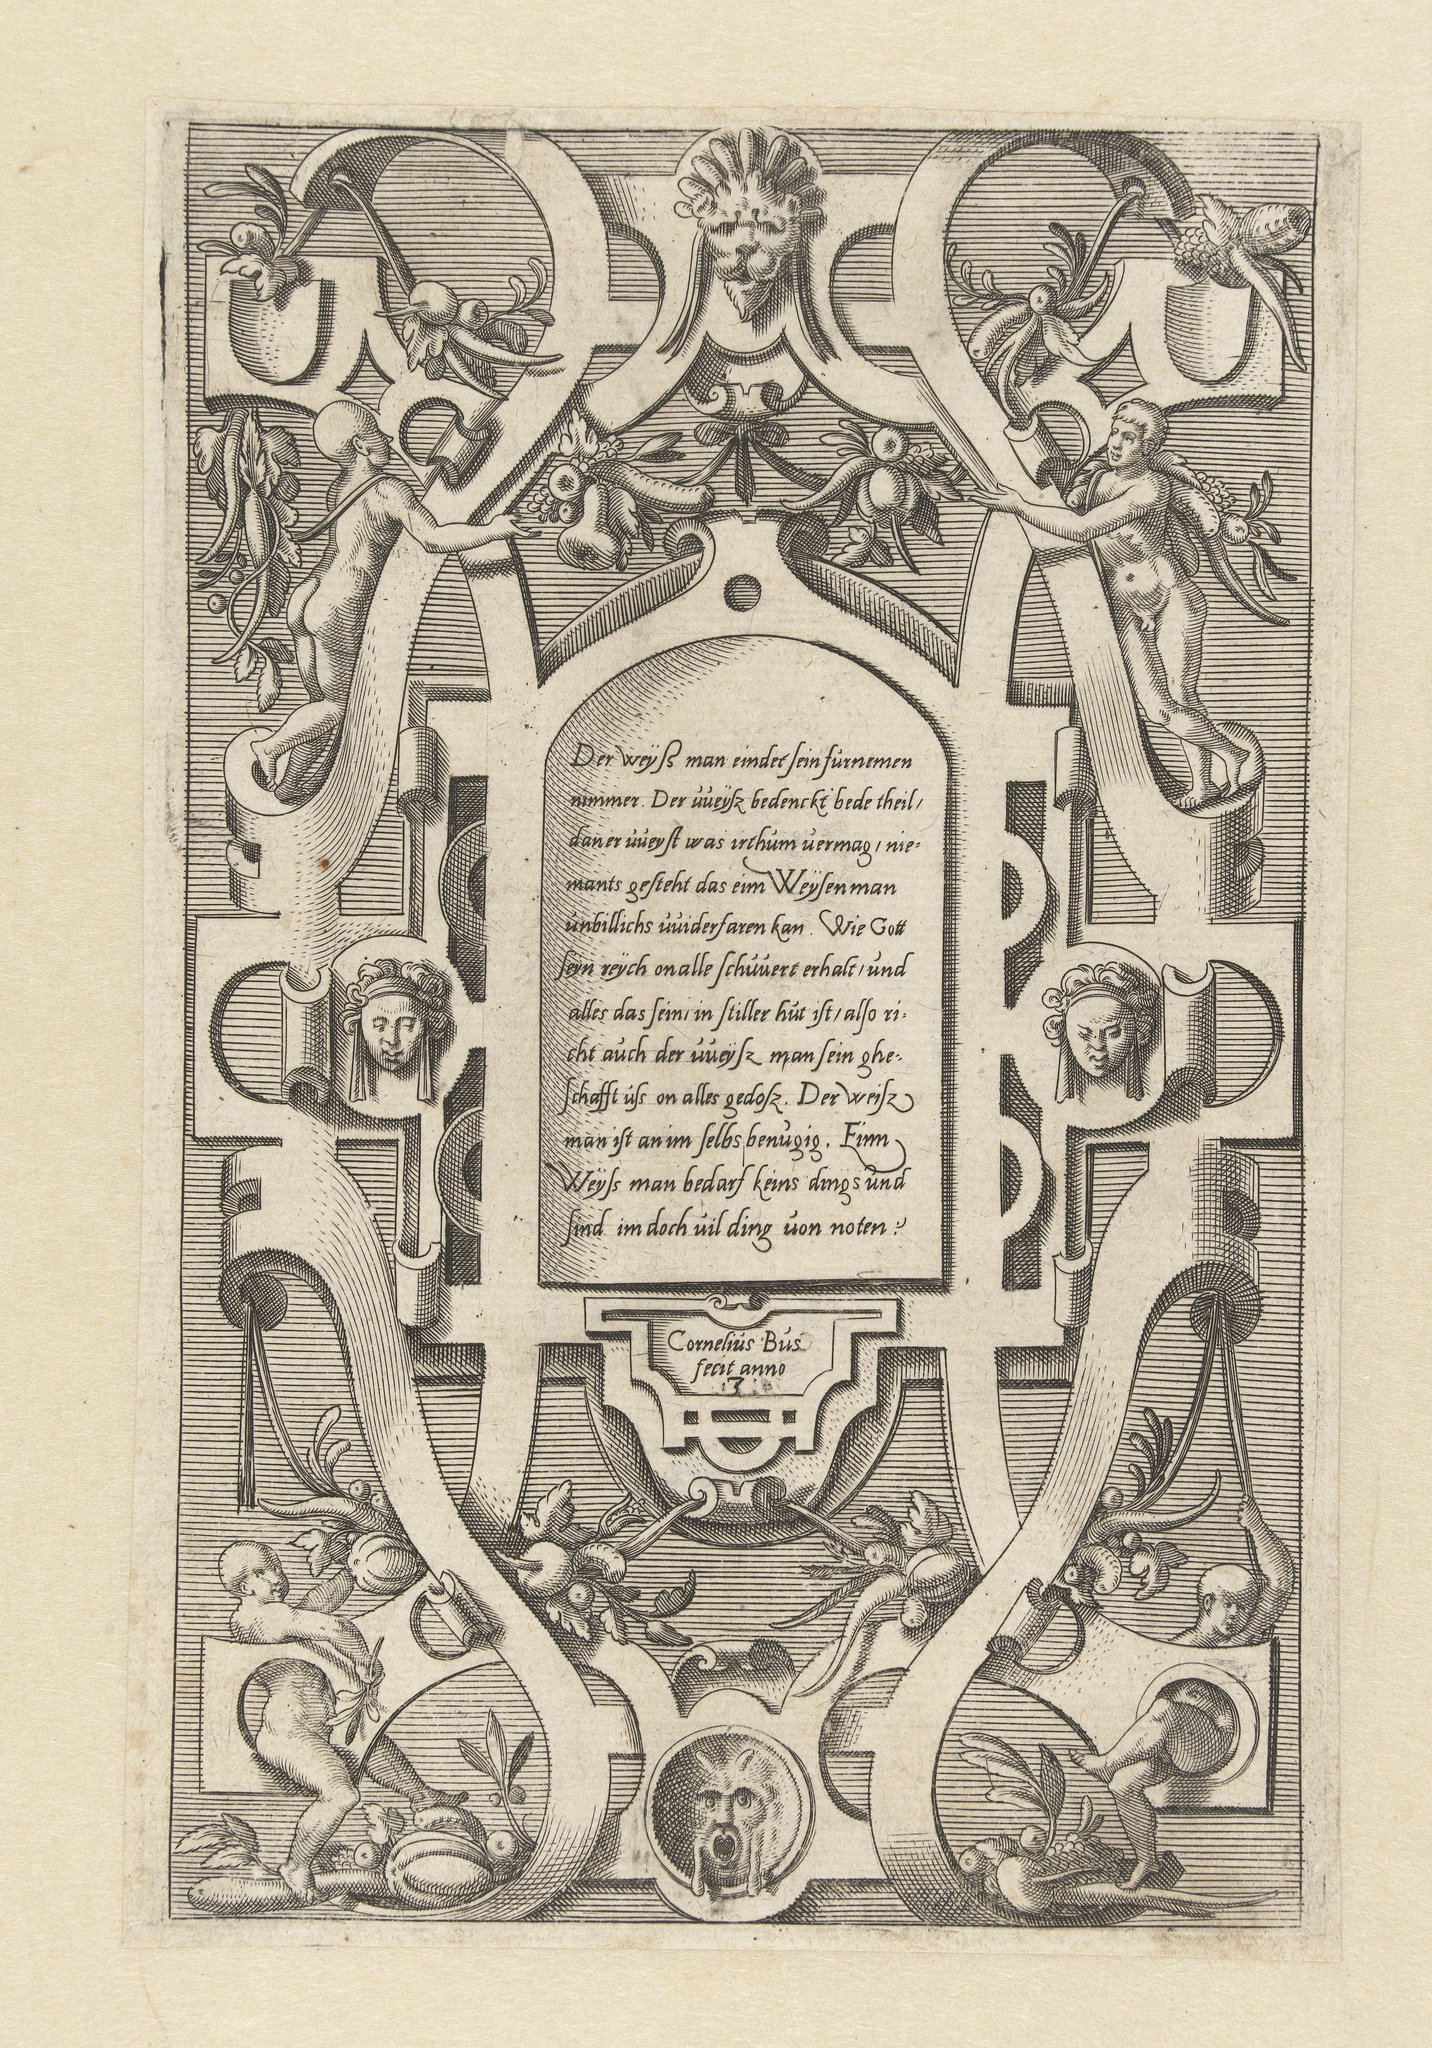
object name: print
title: Der weijss man eindet sein furnemen nimmer (...)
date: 1554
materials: paper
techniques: engraving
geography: paris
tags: scrollwork, strapwork ~ ornament, proverbs, sayings, etc., ornament ~ cartouche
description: Gearceerde achtergrond. Een van 3 bladen uit een serie van 5.